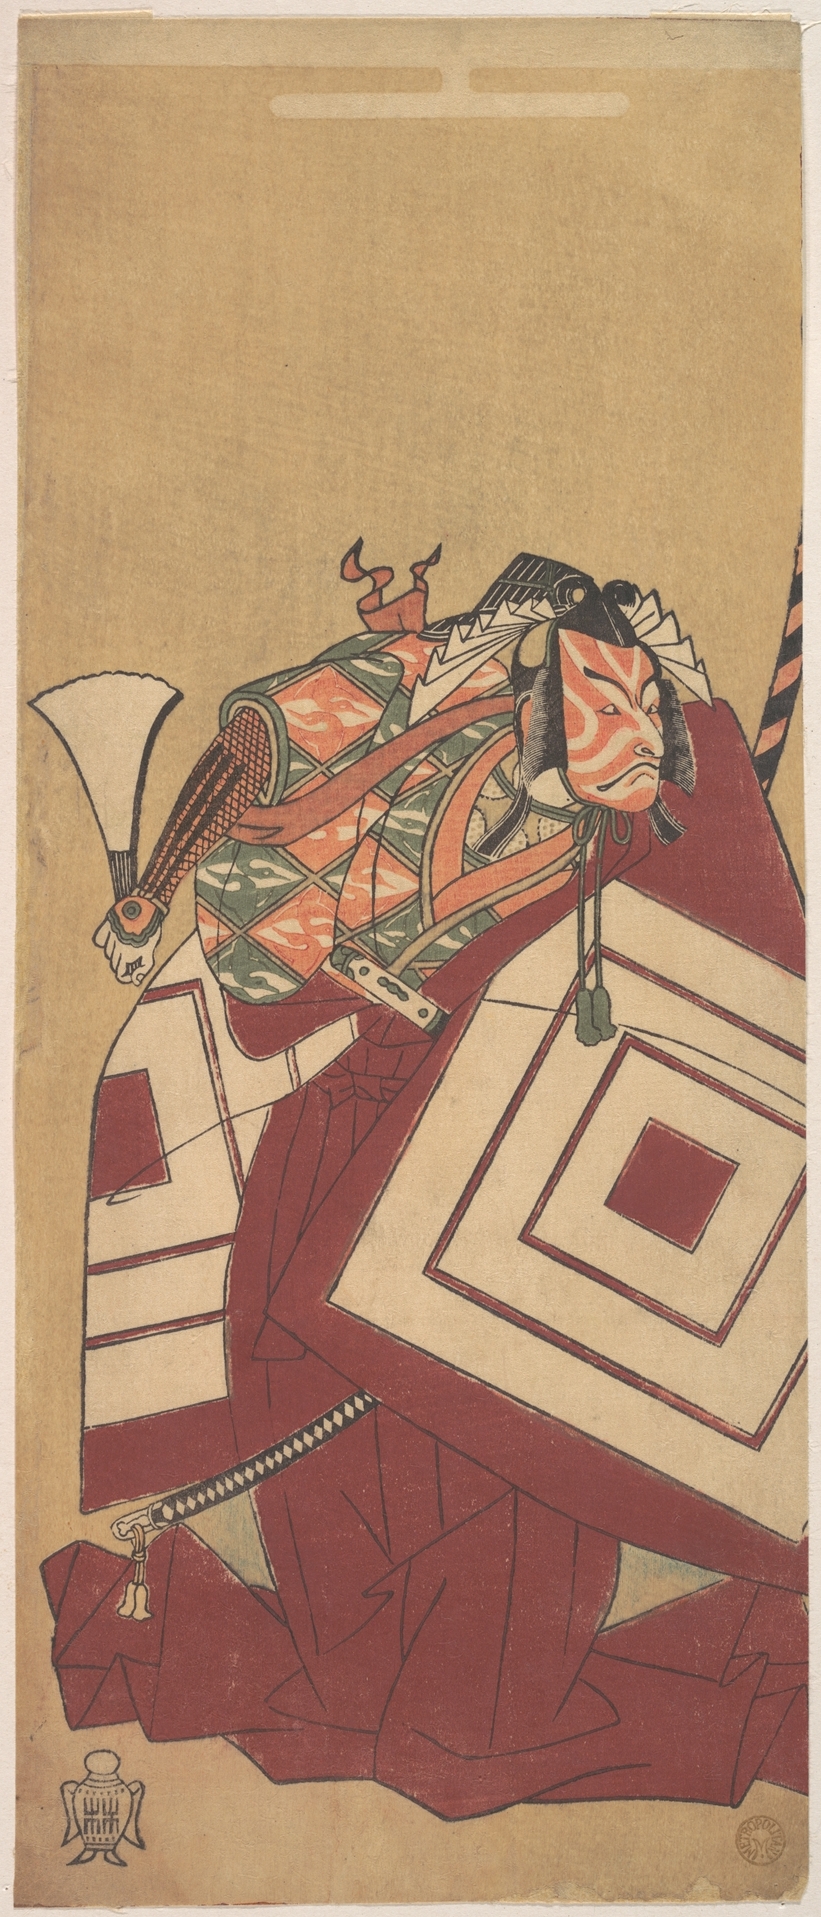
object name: woodblock print nishiki e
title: The Fifth Ichikawa Danjuro as Kisou Takiguchi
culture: japanese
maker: katsukawa shunshō 勝川春章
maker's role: artist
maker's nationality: japanese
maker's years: 1726-1792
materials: ink, paper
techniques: nishiki e, woodblock print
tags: men,actors